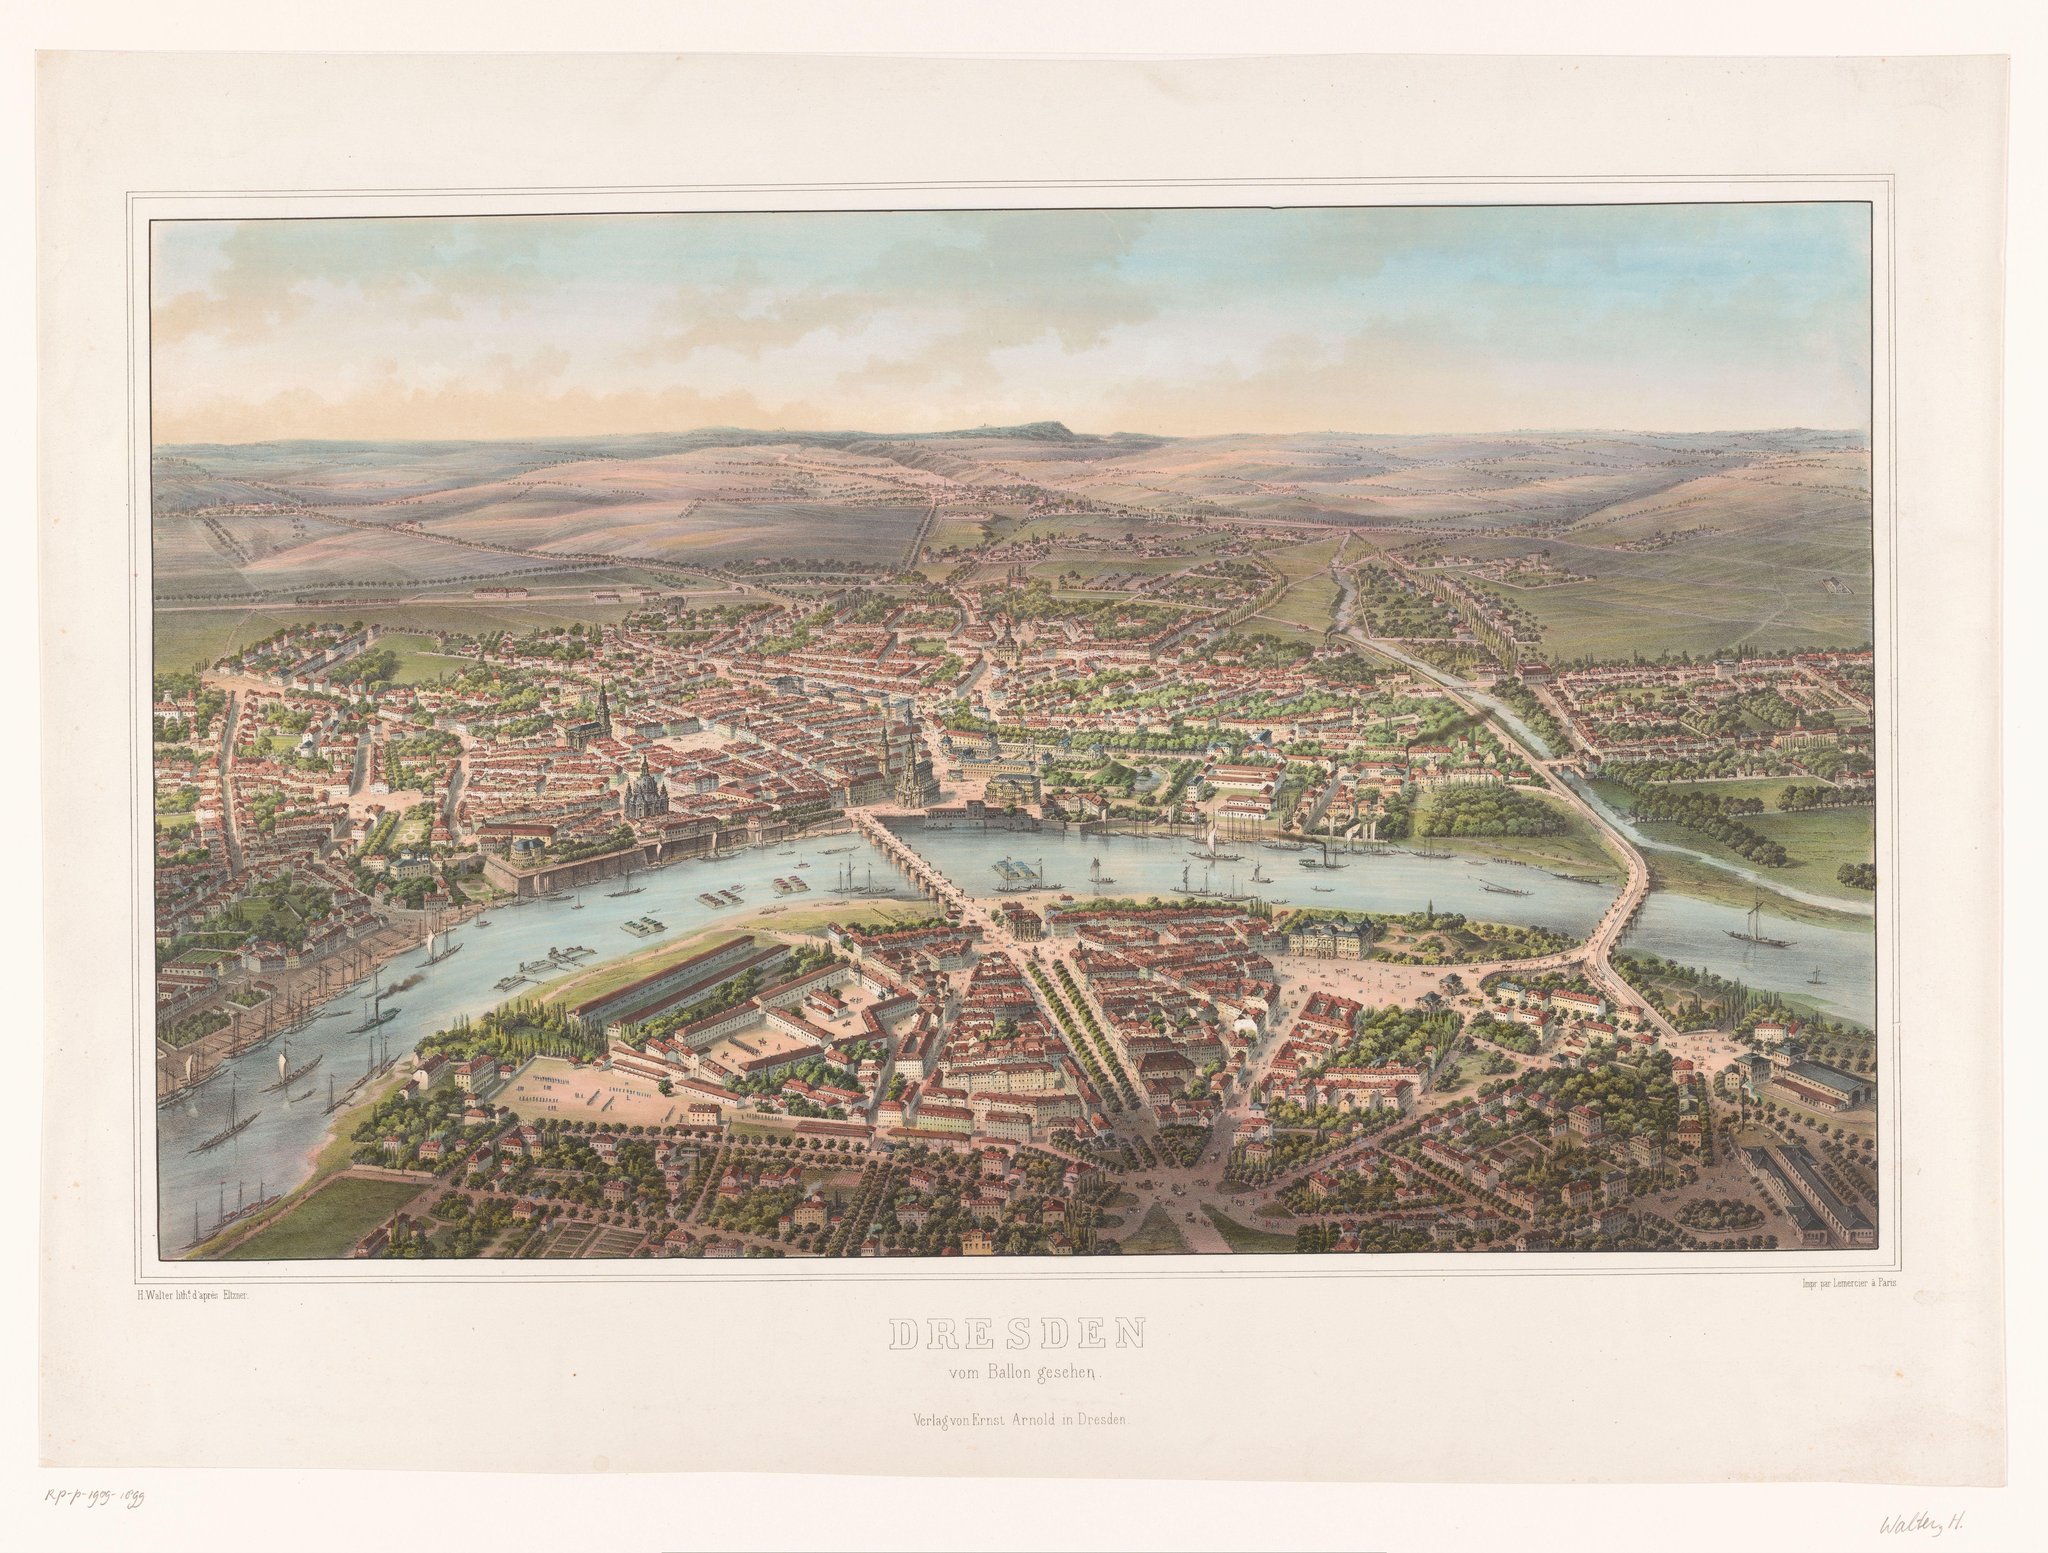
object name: print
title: Dresden, vom Ballon gesehen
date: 1855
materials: paper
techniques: hand coloring, lithograph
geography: dresden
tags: city-view, and landscape with man-made constructions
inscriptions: check stamp